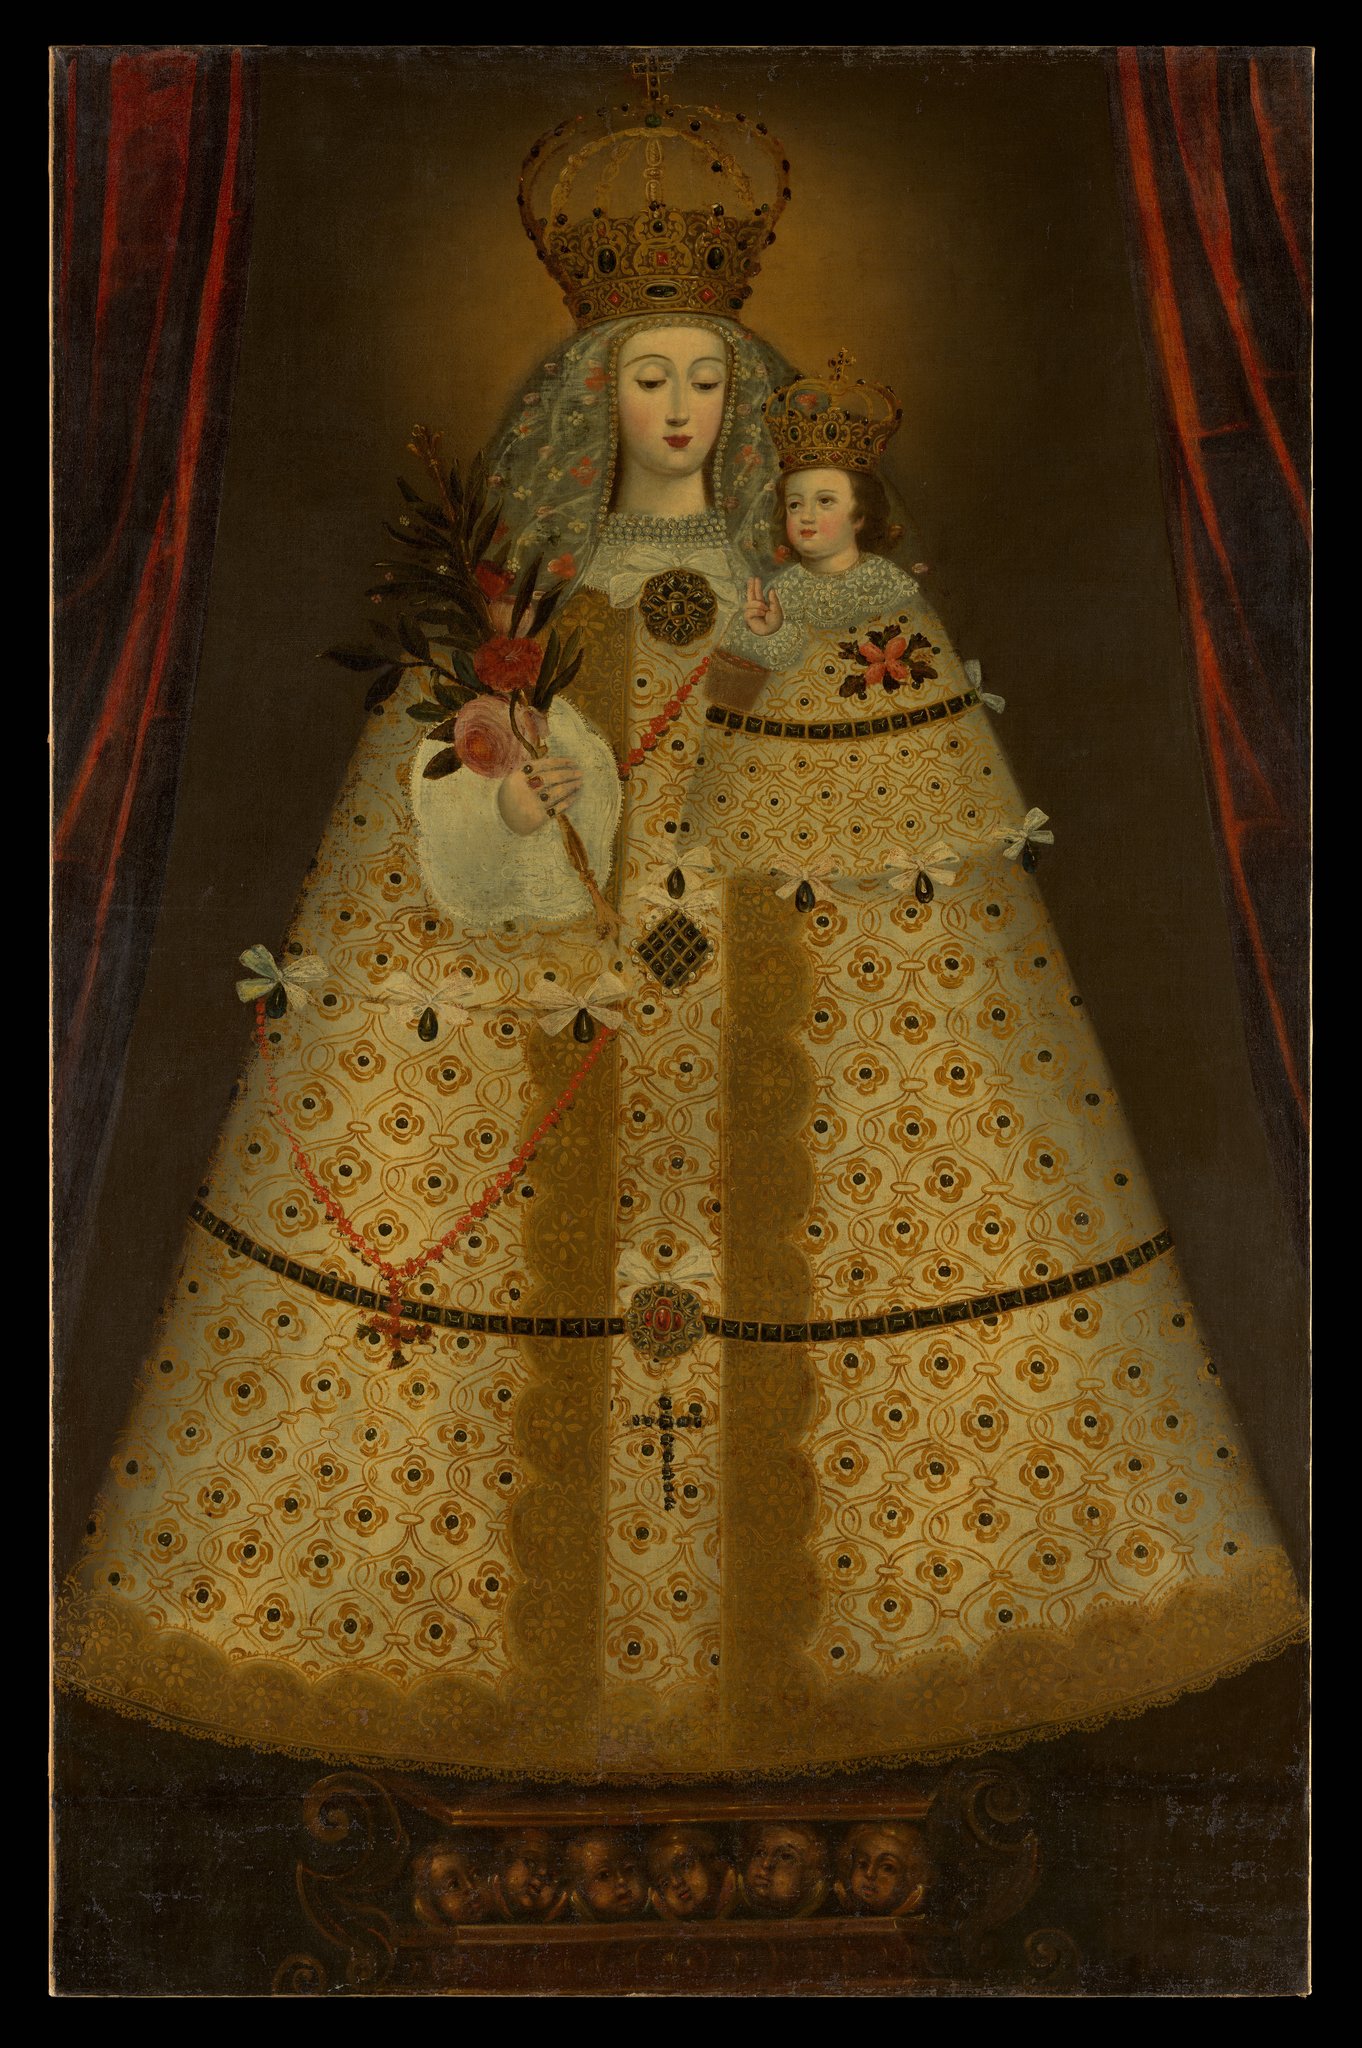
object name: painting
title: Our Lady of Guápulo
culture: peruvian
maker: peruvian (cuzco) painter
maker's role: artist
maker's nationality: peruvian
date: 1701-1800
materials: canvas, oil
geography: peru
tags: christ,madonna and child,virgin mary